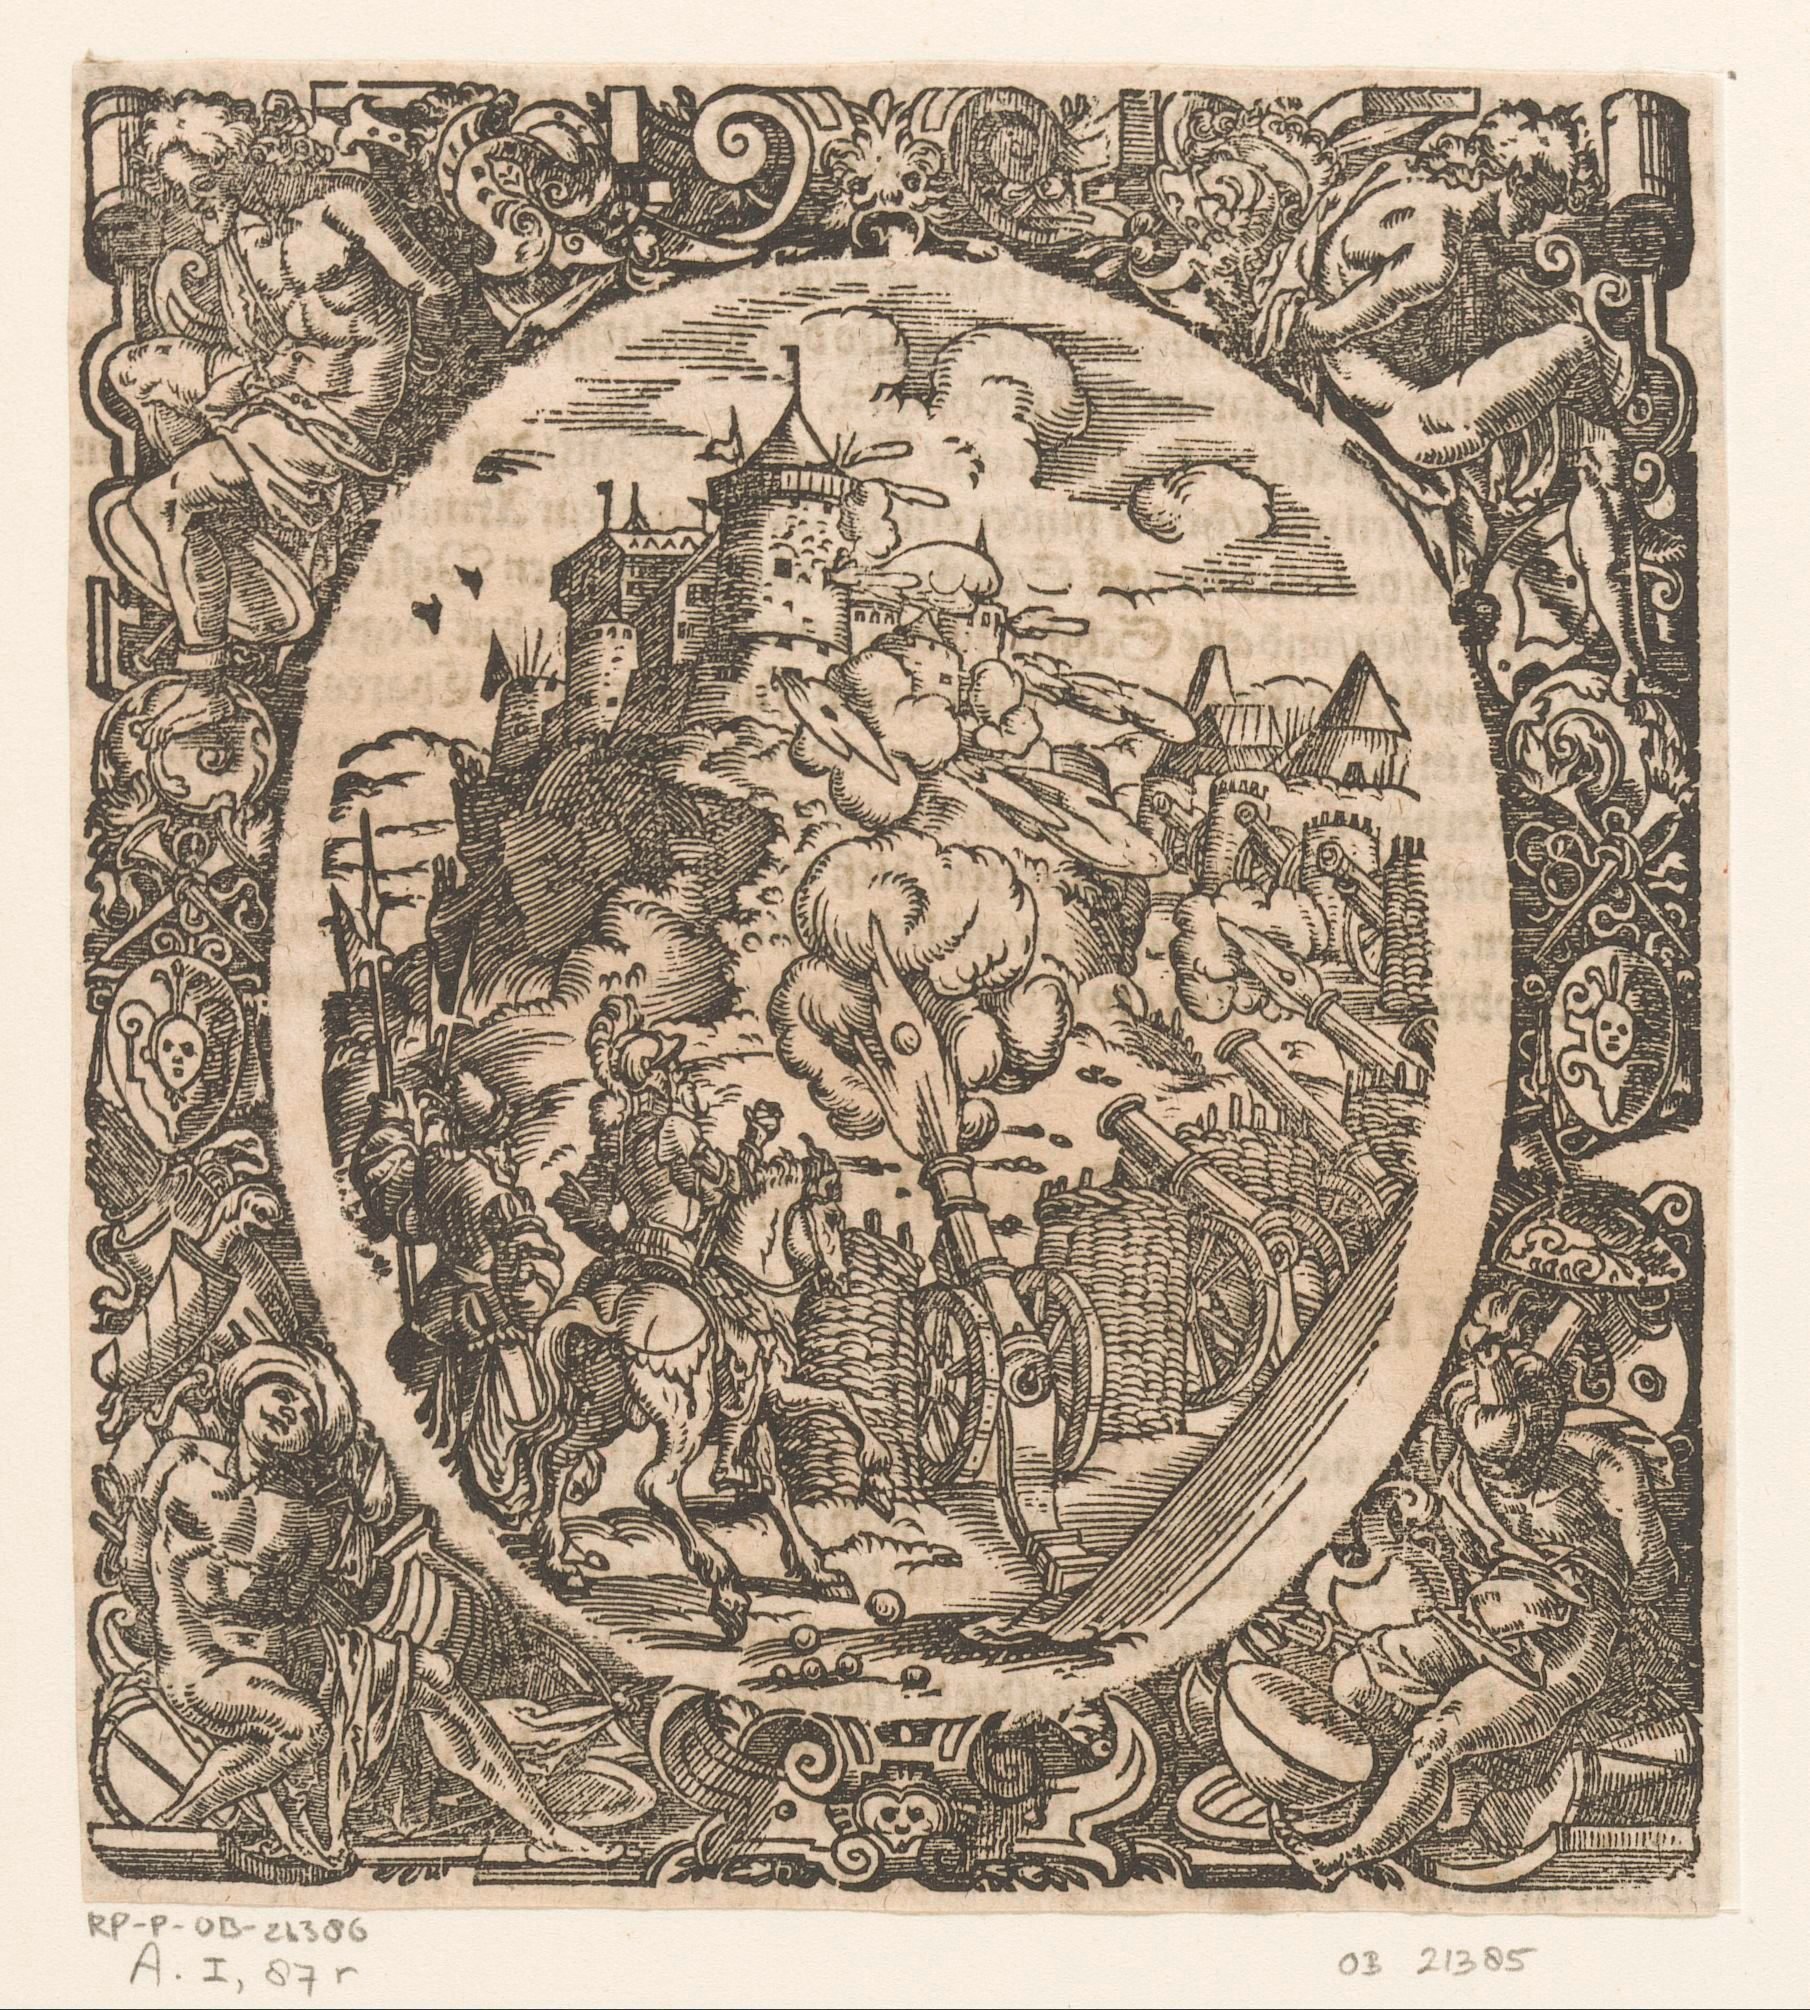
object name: print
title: Beschieten van een kasteel op een heuvel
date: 1573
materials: paper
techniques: woodcut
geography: nuremberg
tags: firearms: cannon, warfare; military affairs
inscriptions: collector's mark: Lugt 240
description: Zowel de voorstelling als de ornamentrand werd gebruikt voor verschillende edities van Leonhardt Fronspergers Kriegsbuch.